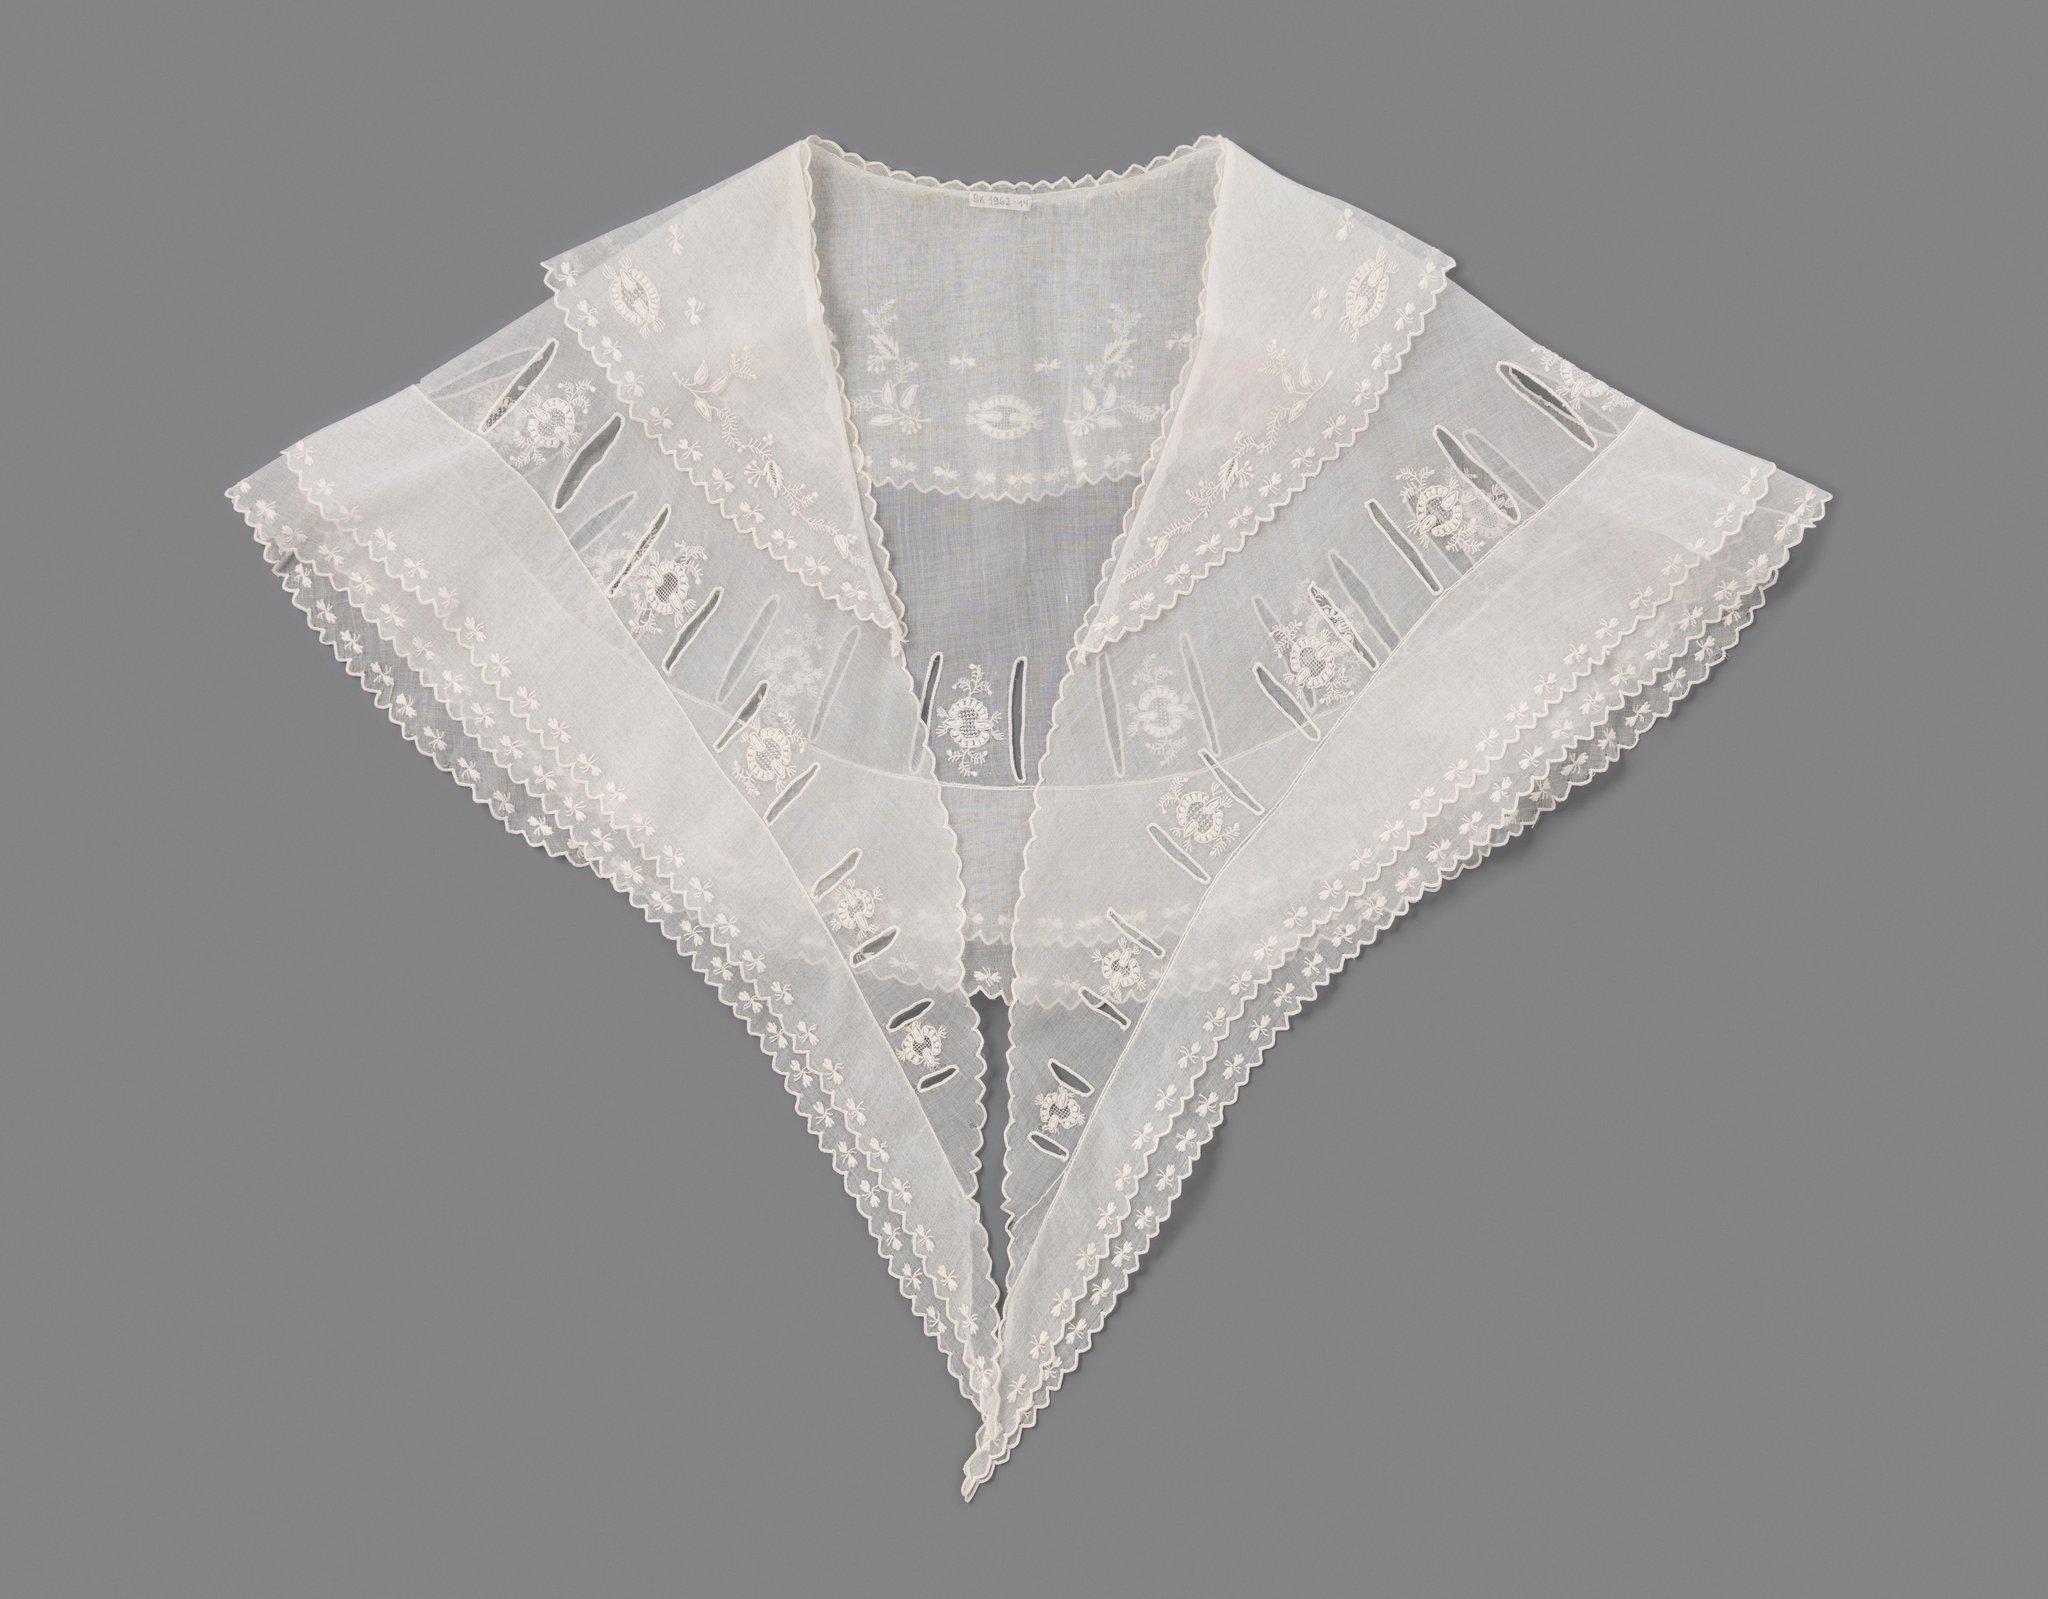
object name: womenswear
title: Fichu met kleine sjaalkraag, van linnen batist versierd met florale en fantasie motieven in witwerk en naaldkantsteken van katoen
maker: Anonymous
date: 1850-1900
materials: cotton, linen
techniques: embroidered, weave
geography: netherlands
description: Fichu met sjaalkraagje, van linnen glasbatist versierd met witwerk. Model: in schoudervorm gesneden, rond van achter en puntig van voren. Verdubbeld met een sjaalkraagje en afgewerkt met een dubbele, glad aangezette strook. Tegen de strook een reeks van dwarssleuven voor een rijglint. Ornament: verspreide ovaaltjes in plumetisborduurwerk met dikke parelranden en fijne naadlkantsteekjes in het hart worden afgewisseld met bladrandjes, terwijl langs de fijngeschulpte rand motiefjes lopen, die op vliegjes gelijken.